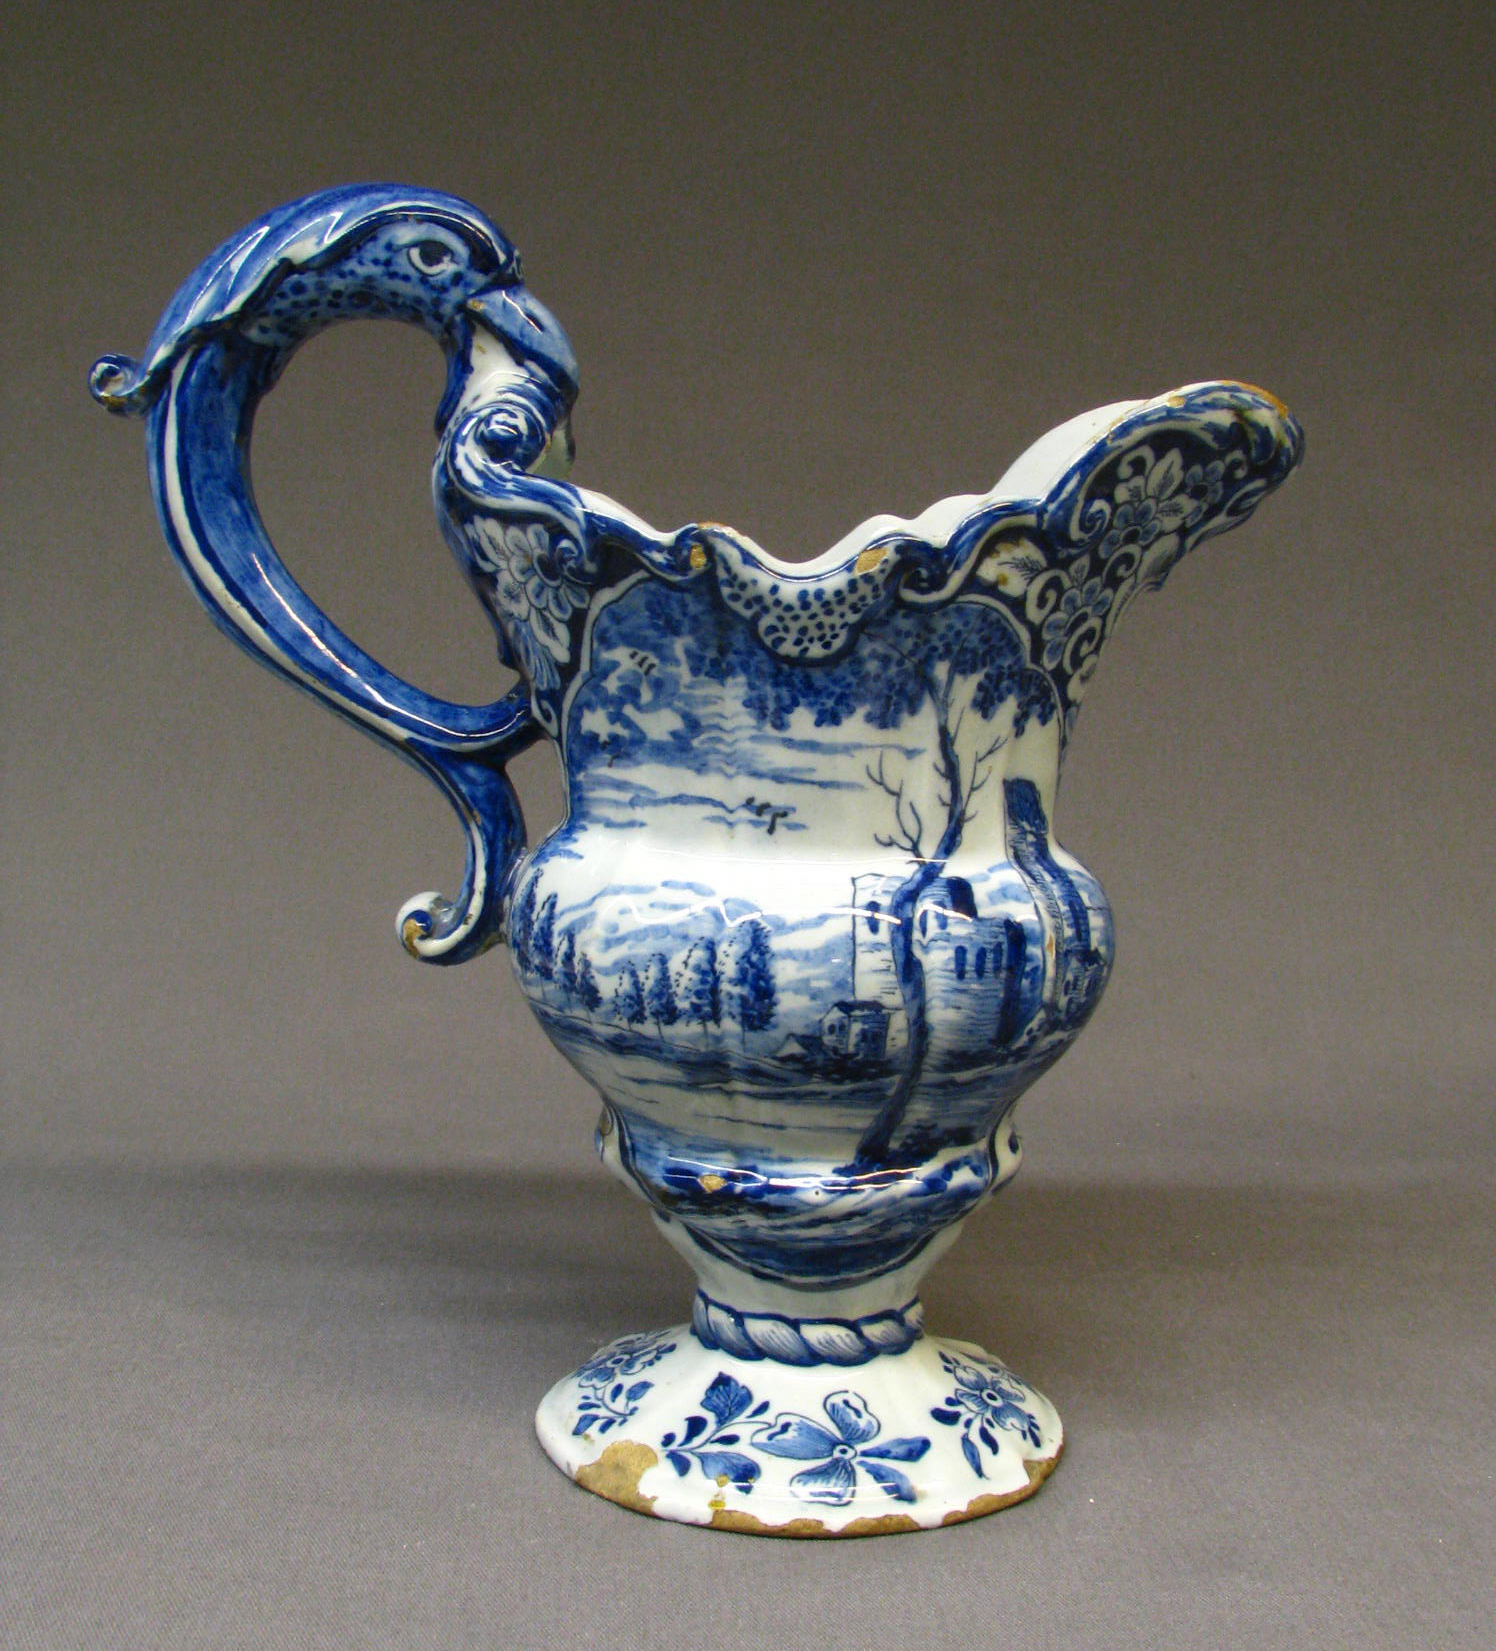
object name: ewer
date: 1710-1760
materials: earthenware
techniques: glazing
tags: houses,flowers,trees